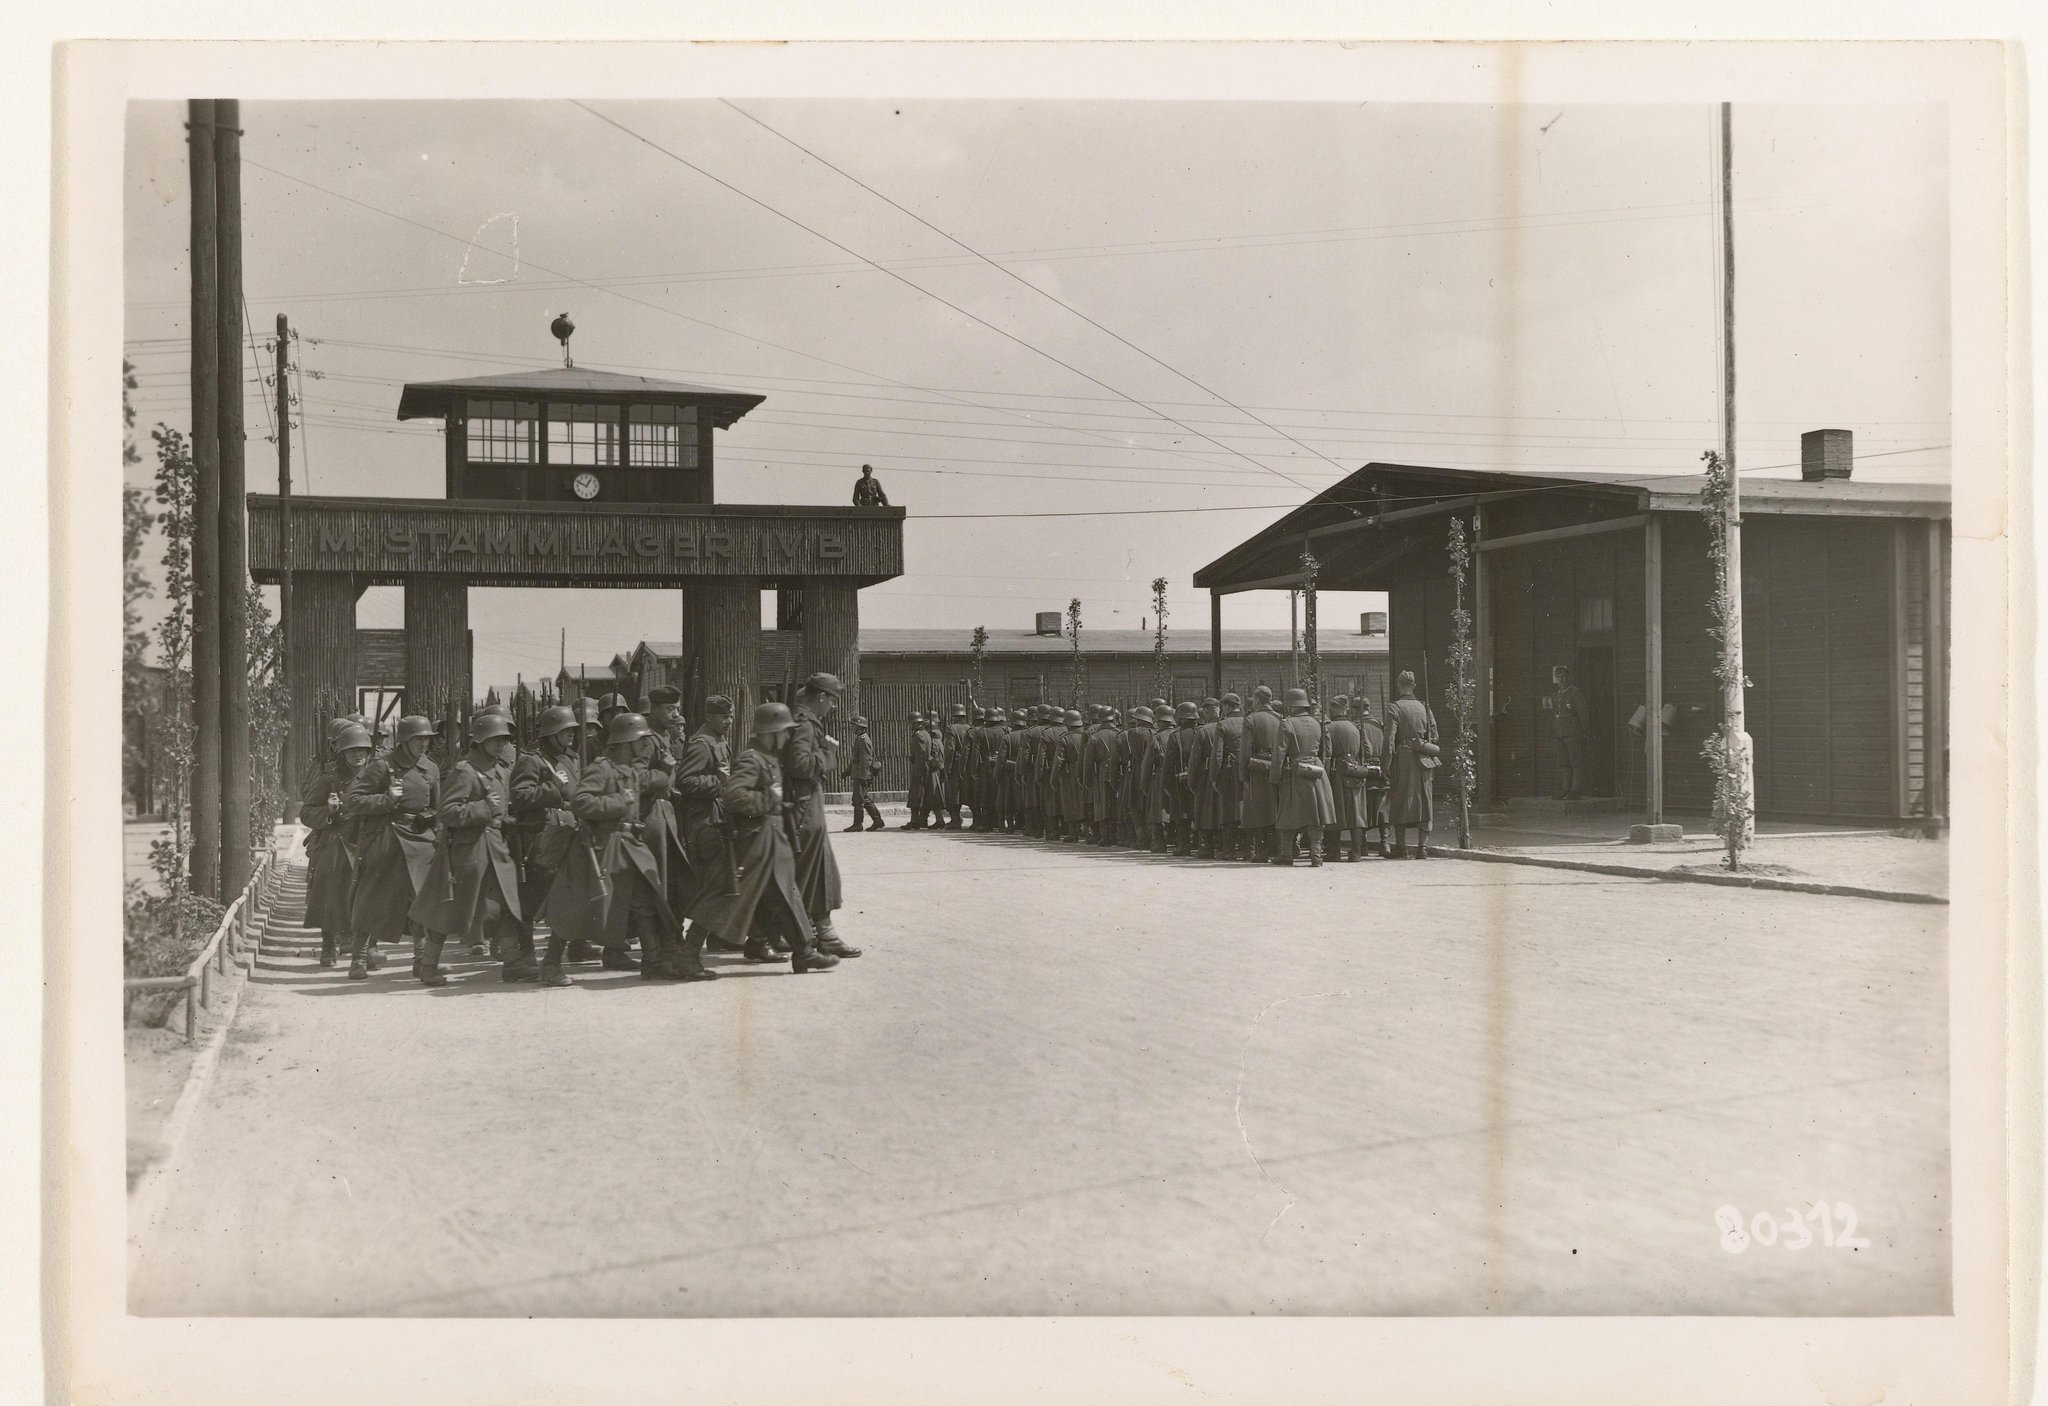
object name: photograph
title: Duitse militairen in kamp Mühlberg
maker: dick w.b. van maarseveen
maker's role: fotograaf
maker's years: 1905-1990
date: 1943-1945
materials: photographic support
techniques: gelatin silver print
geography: muhlberg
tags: the hague, dick w.b. van maarseveen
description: Duitse militairen exerceren bij de ingang van kamp Mühlberg. Onderdeel van een groep foto's gemaakt door Dick van Maarseveen in het Duitse krijgsgevangenenkamp Stalag IV B in Mühlberg in de periode 1943-1945.